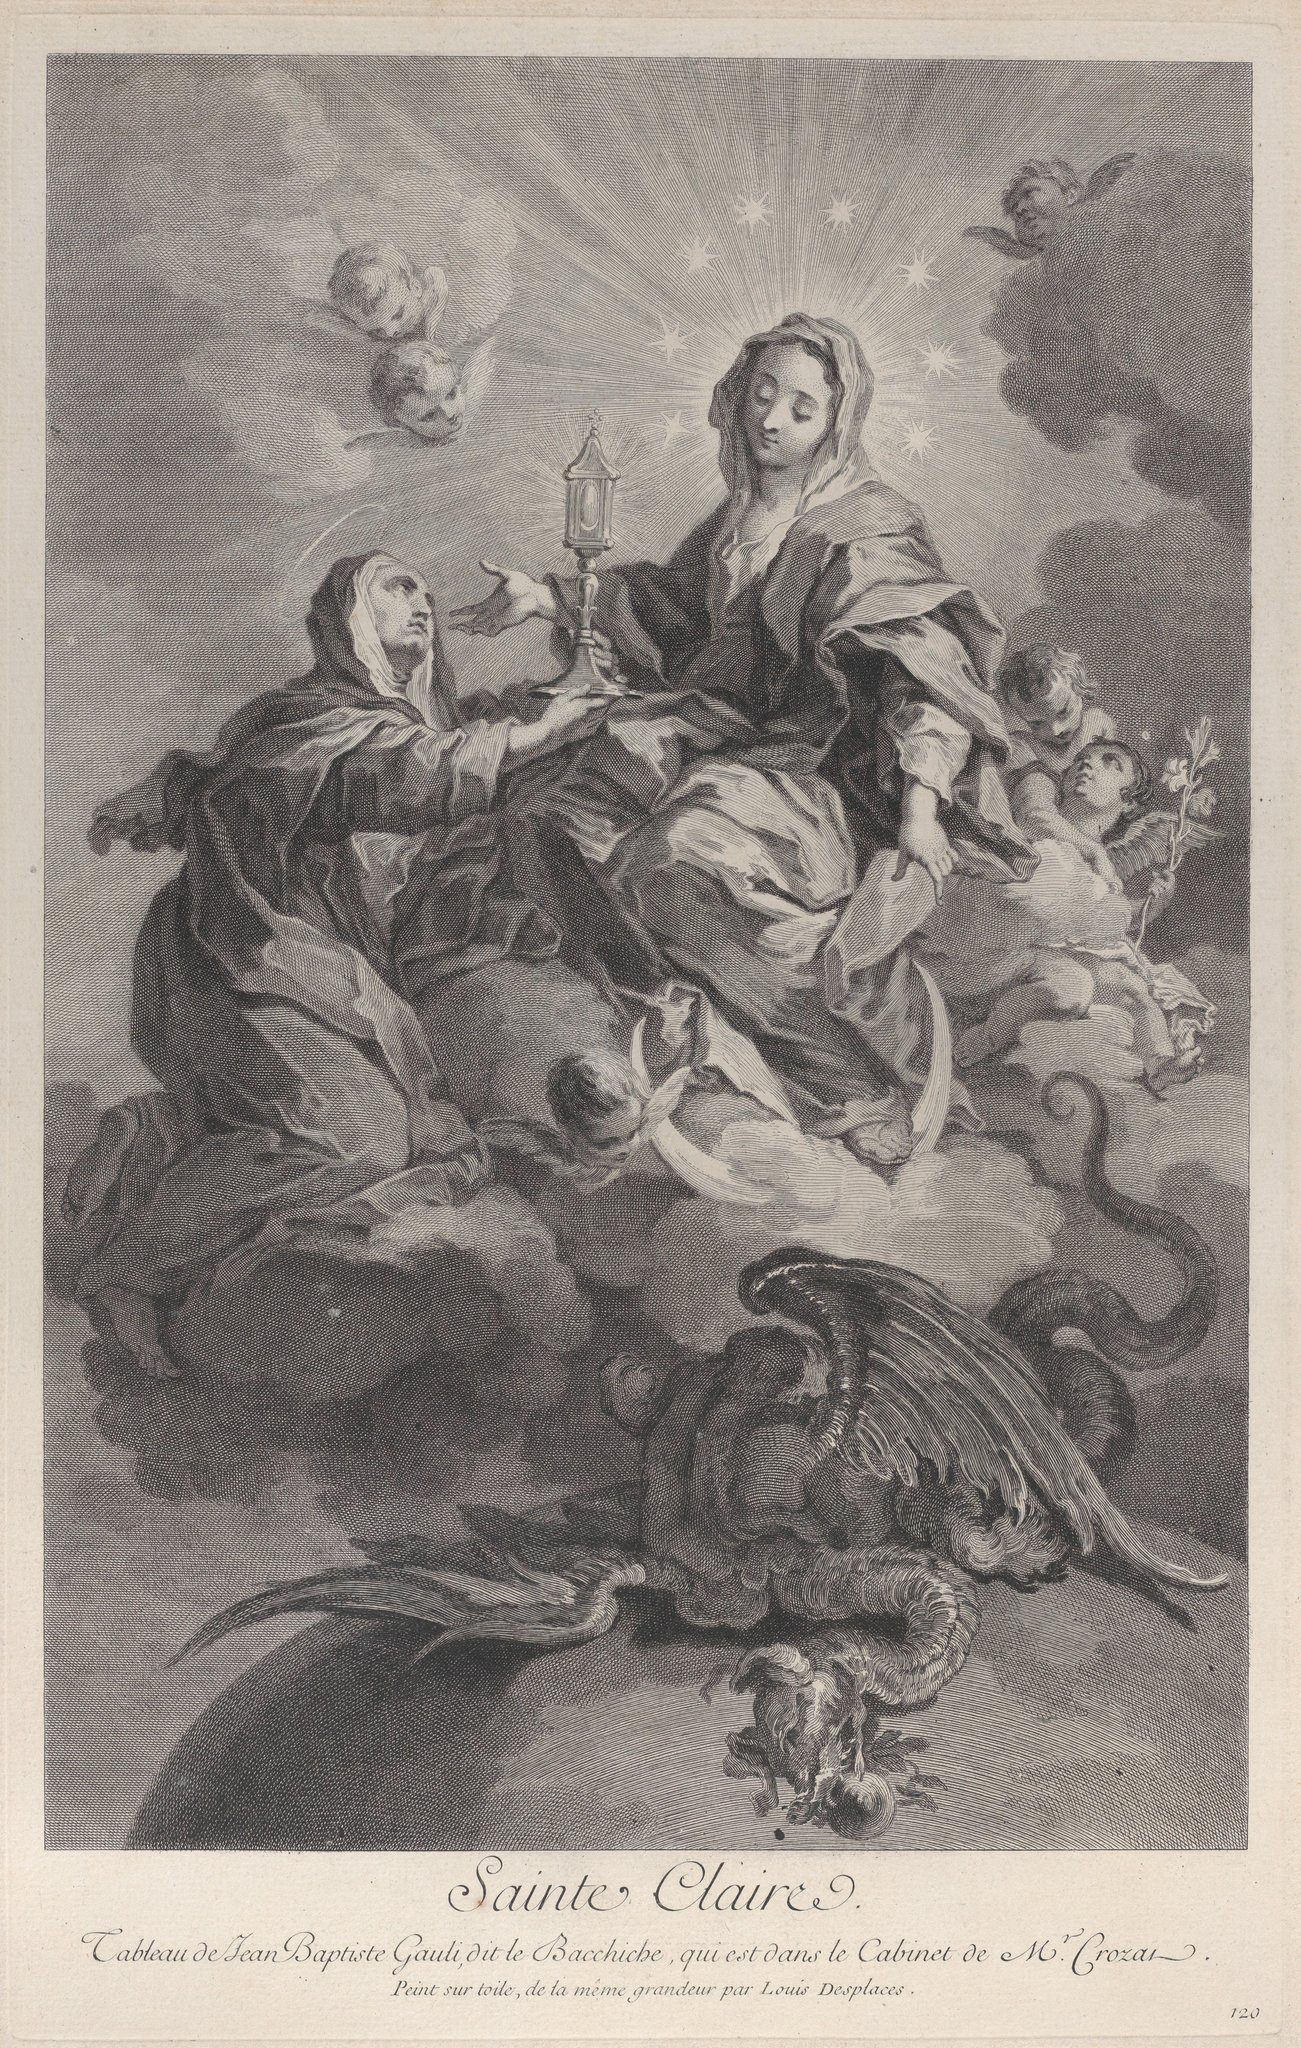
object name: print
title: Saint Clare, seated in the clouds among angels, a dragon below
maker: louis desplaces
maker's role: artist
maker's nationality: french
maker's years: 1682-1739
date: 1729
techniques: engraving, etching